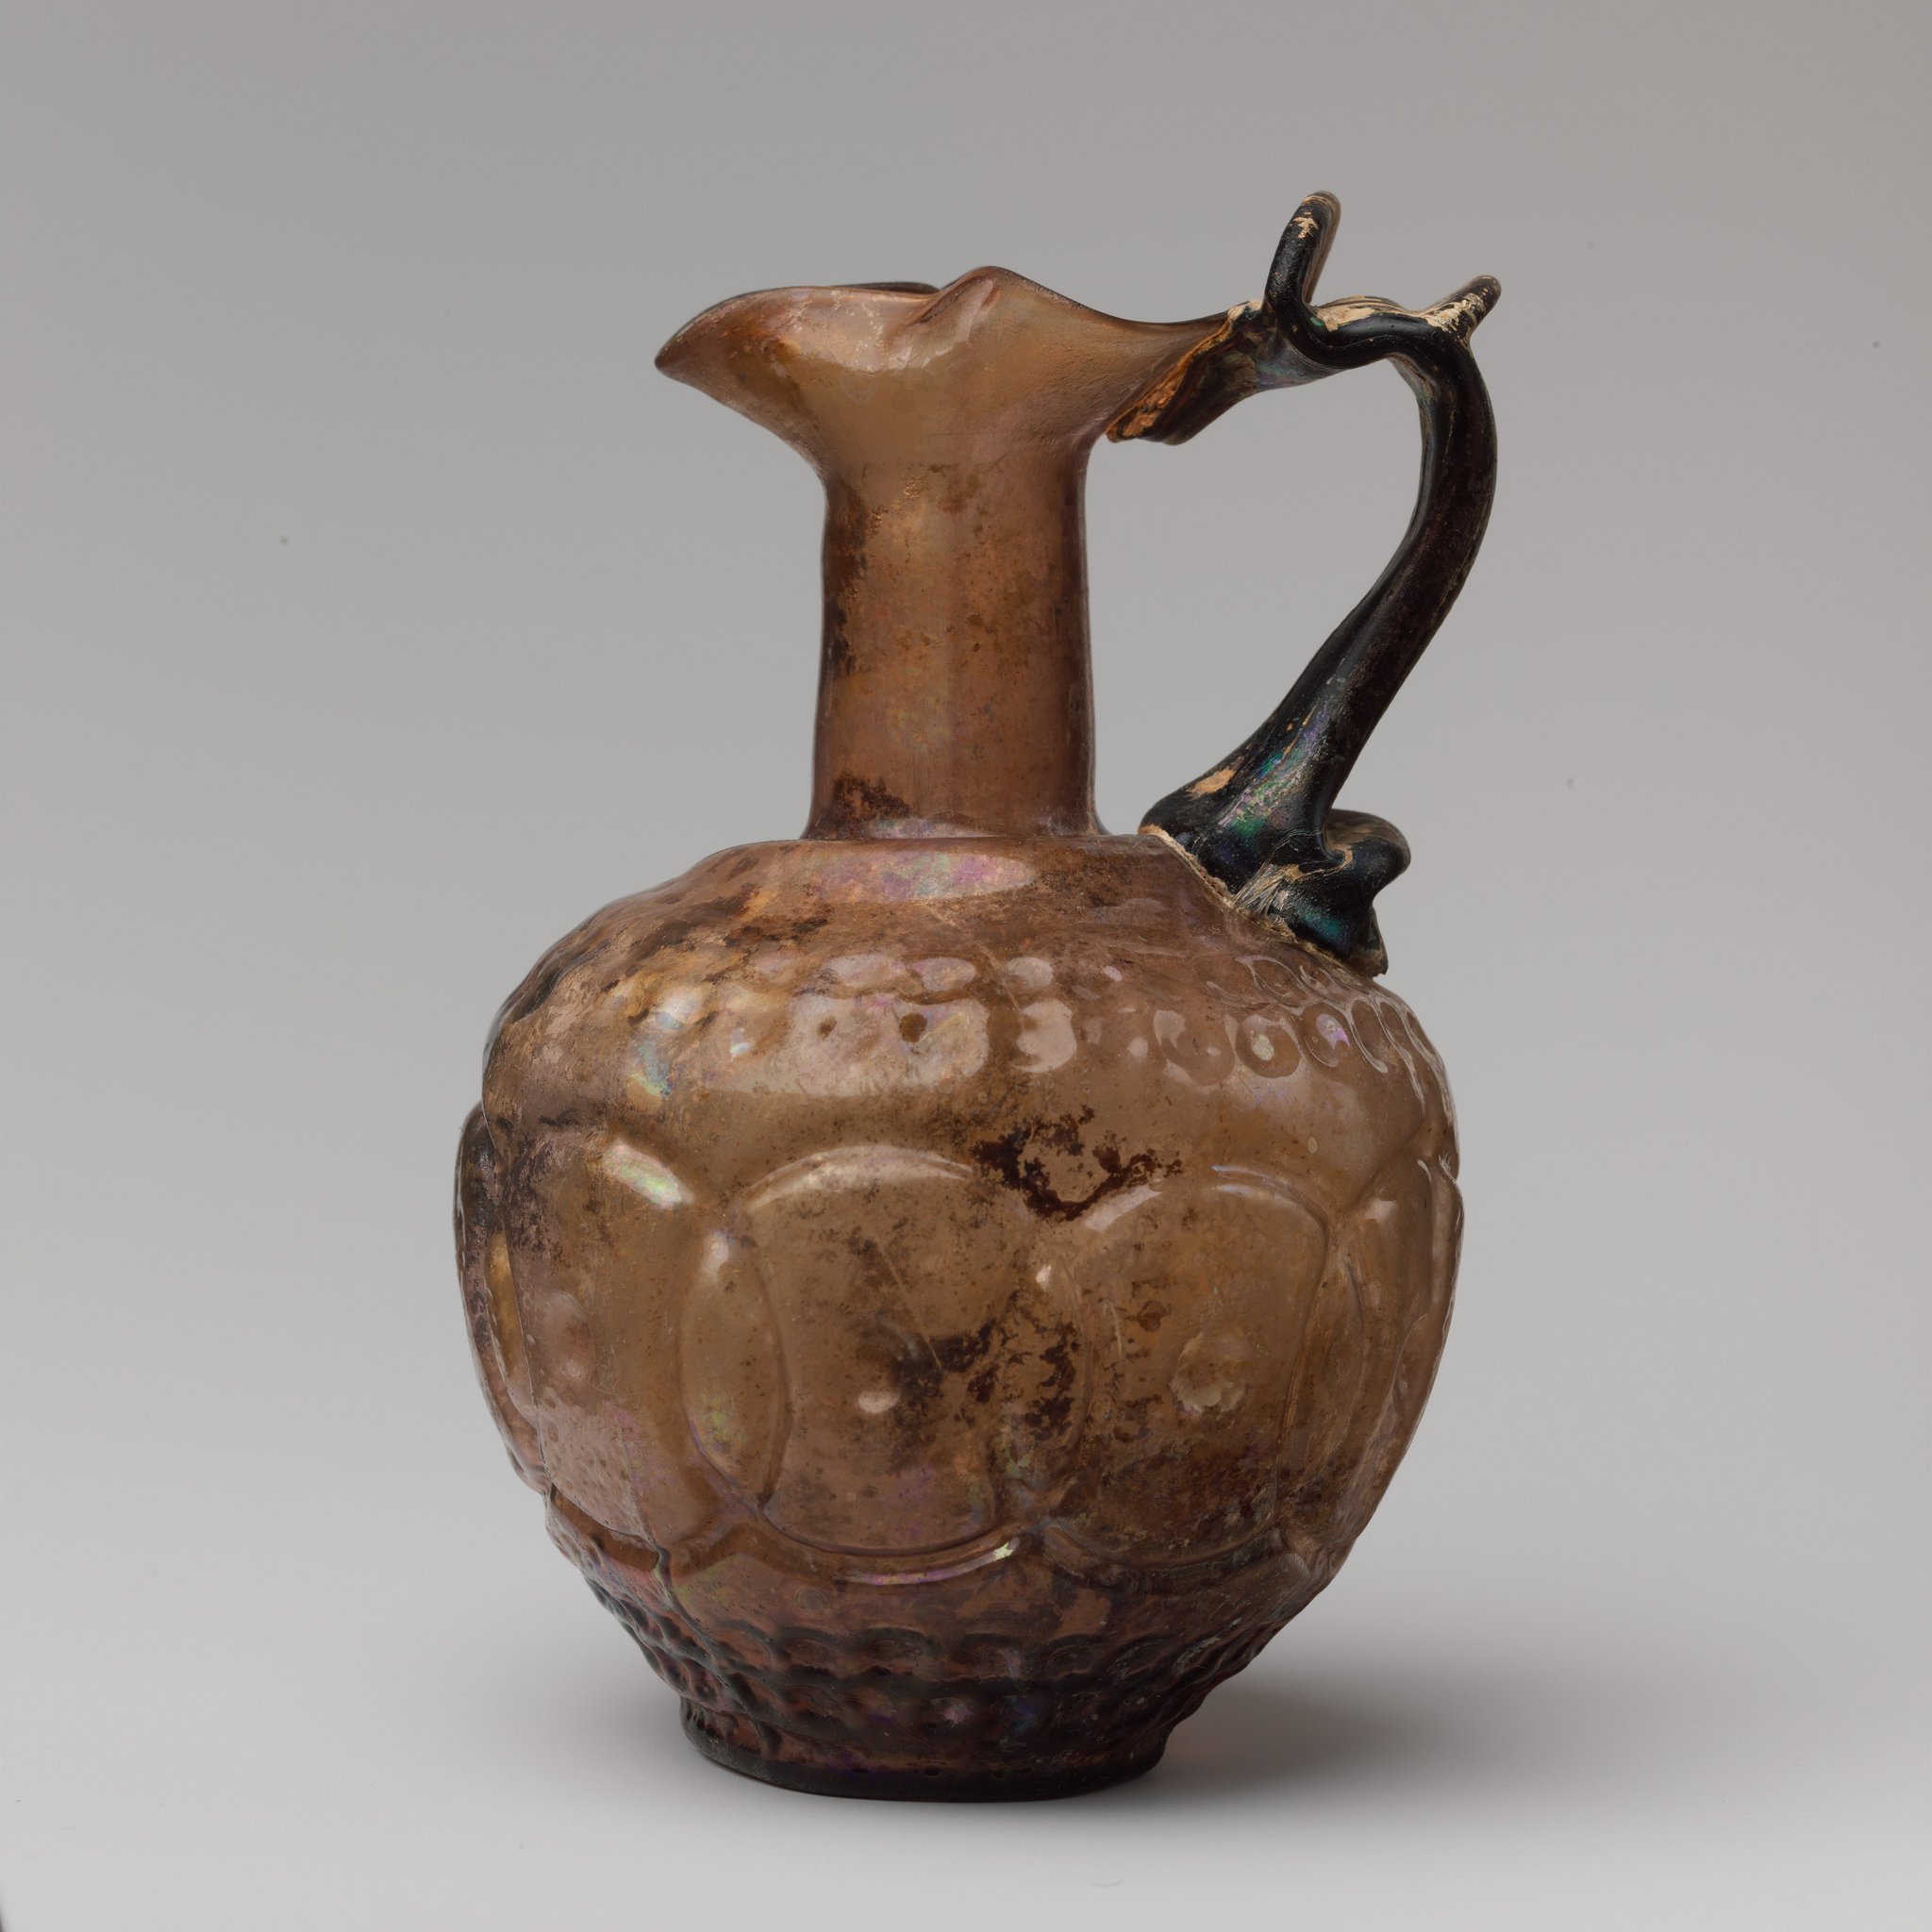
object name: jug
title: Glass jug decorated with intersecting circles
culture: roman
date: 101-300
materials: glass